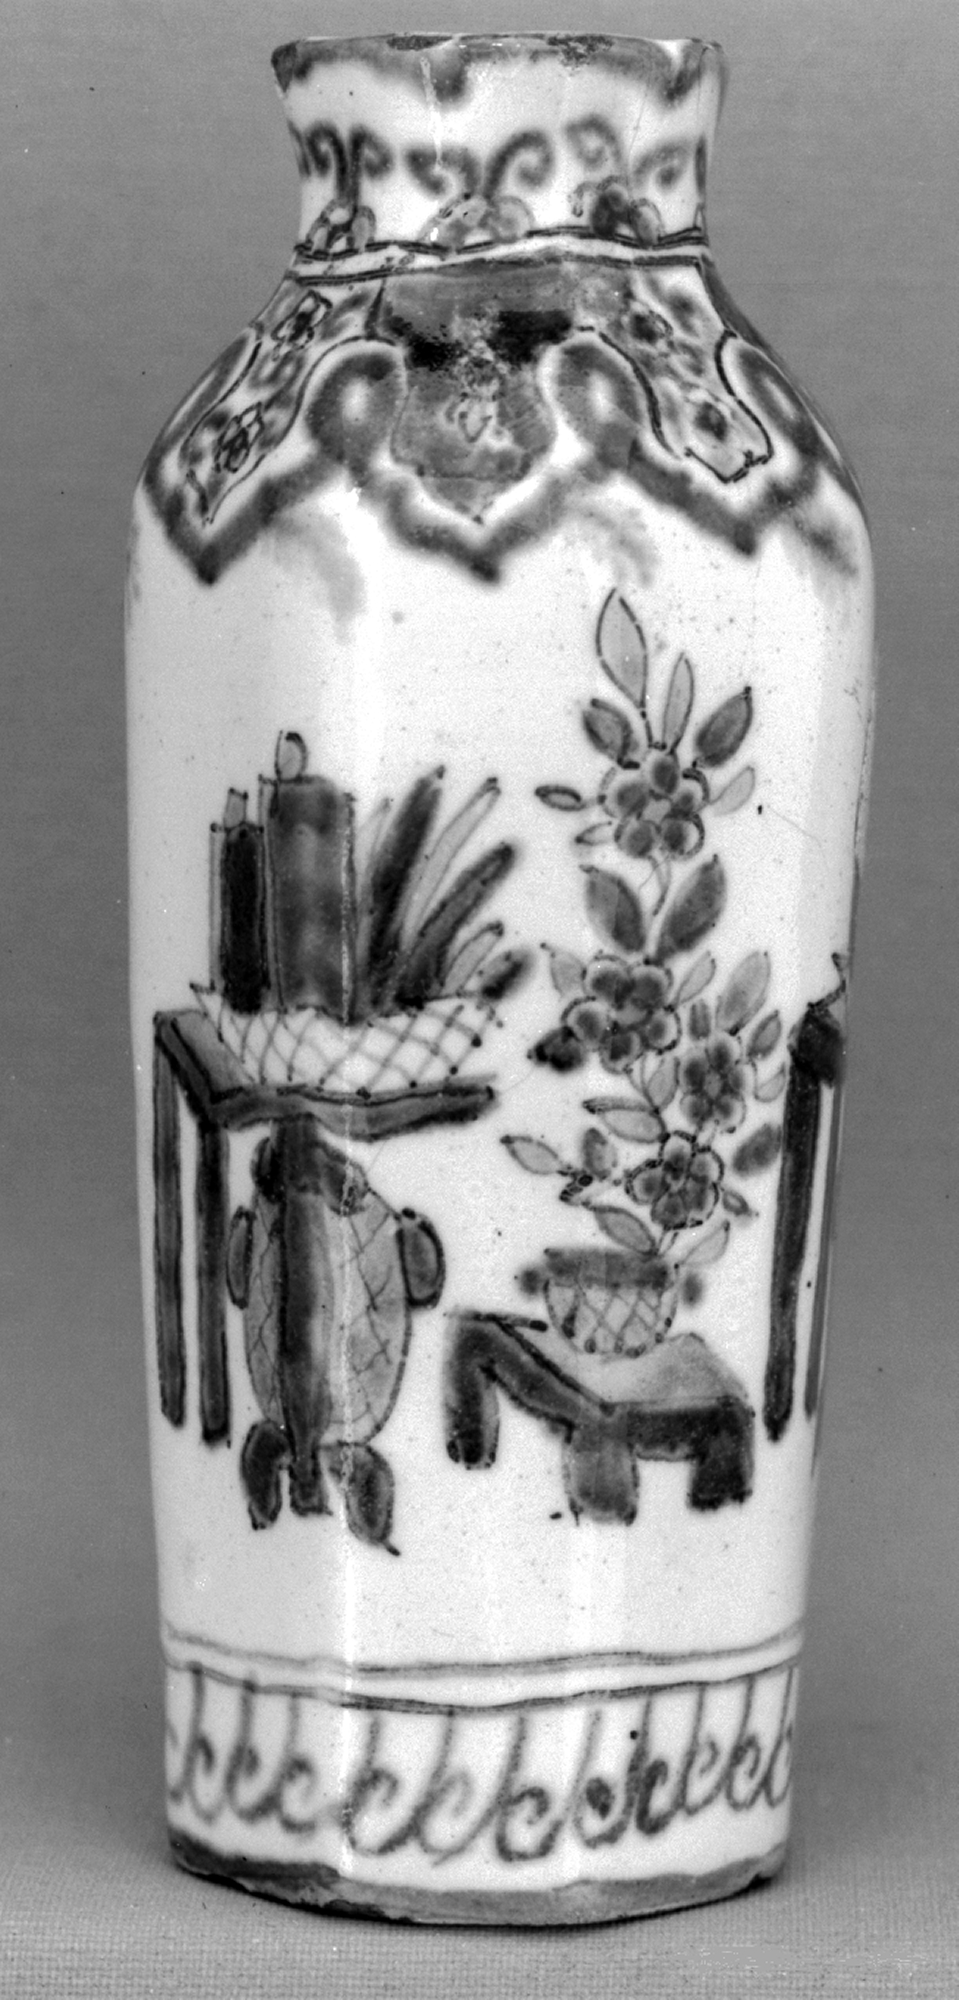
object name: vase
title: Vase (one of a pair)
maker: anthoni pennis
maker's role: maker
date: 1751-1800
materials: earthenware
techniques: glazing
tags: flowers